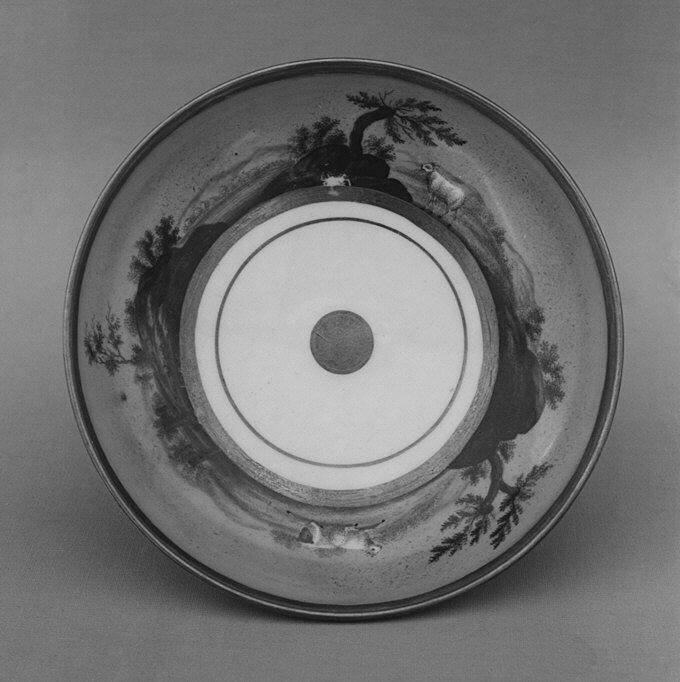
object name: saucer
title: Saucer (one of six) (part of a set)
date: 1820-1830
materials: hard paste porcelain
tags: cows,trees